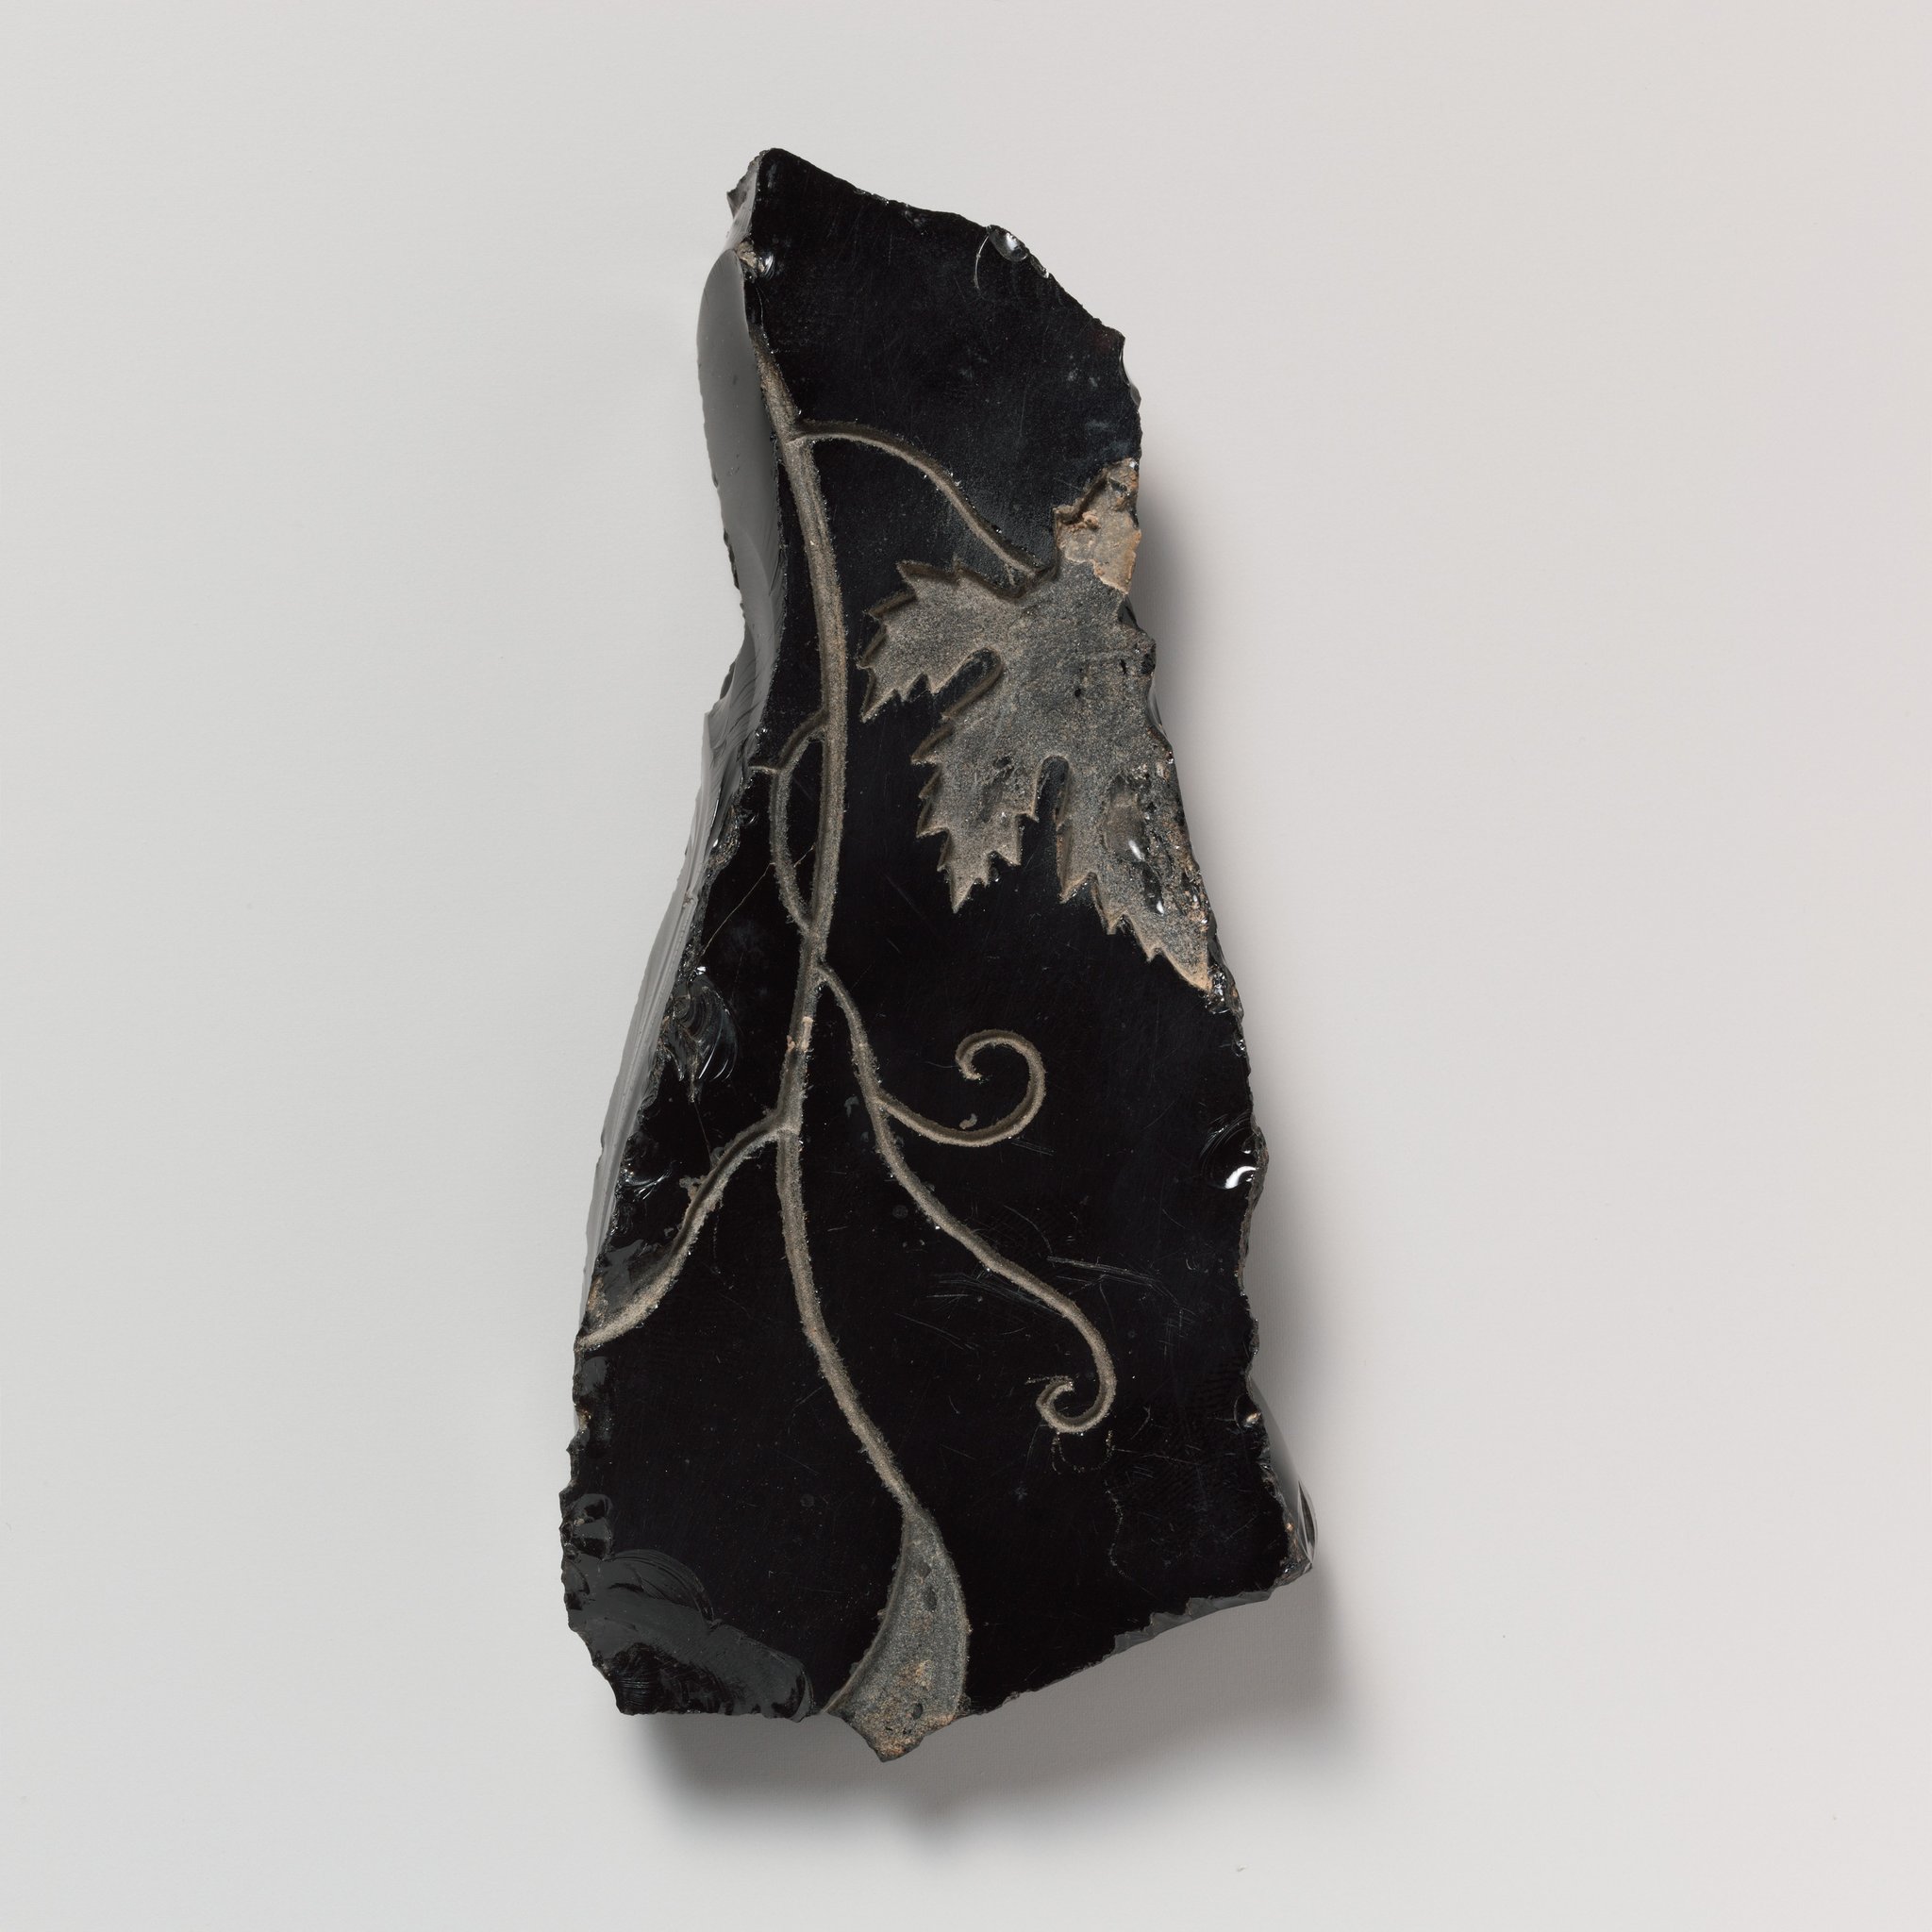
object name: revetment slab fragment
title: Obsidian revetment slab fragment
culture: roman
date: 1-100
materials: obsidian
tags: leaves